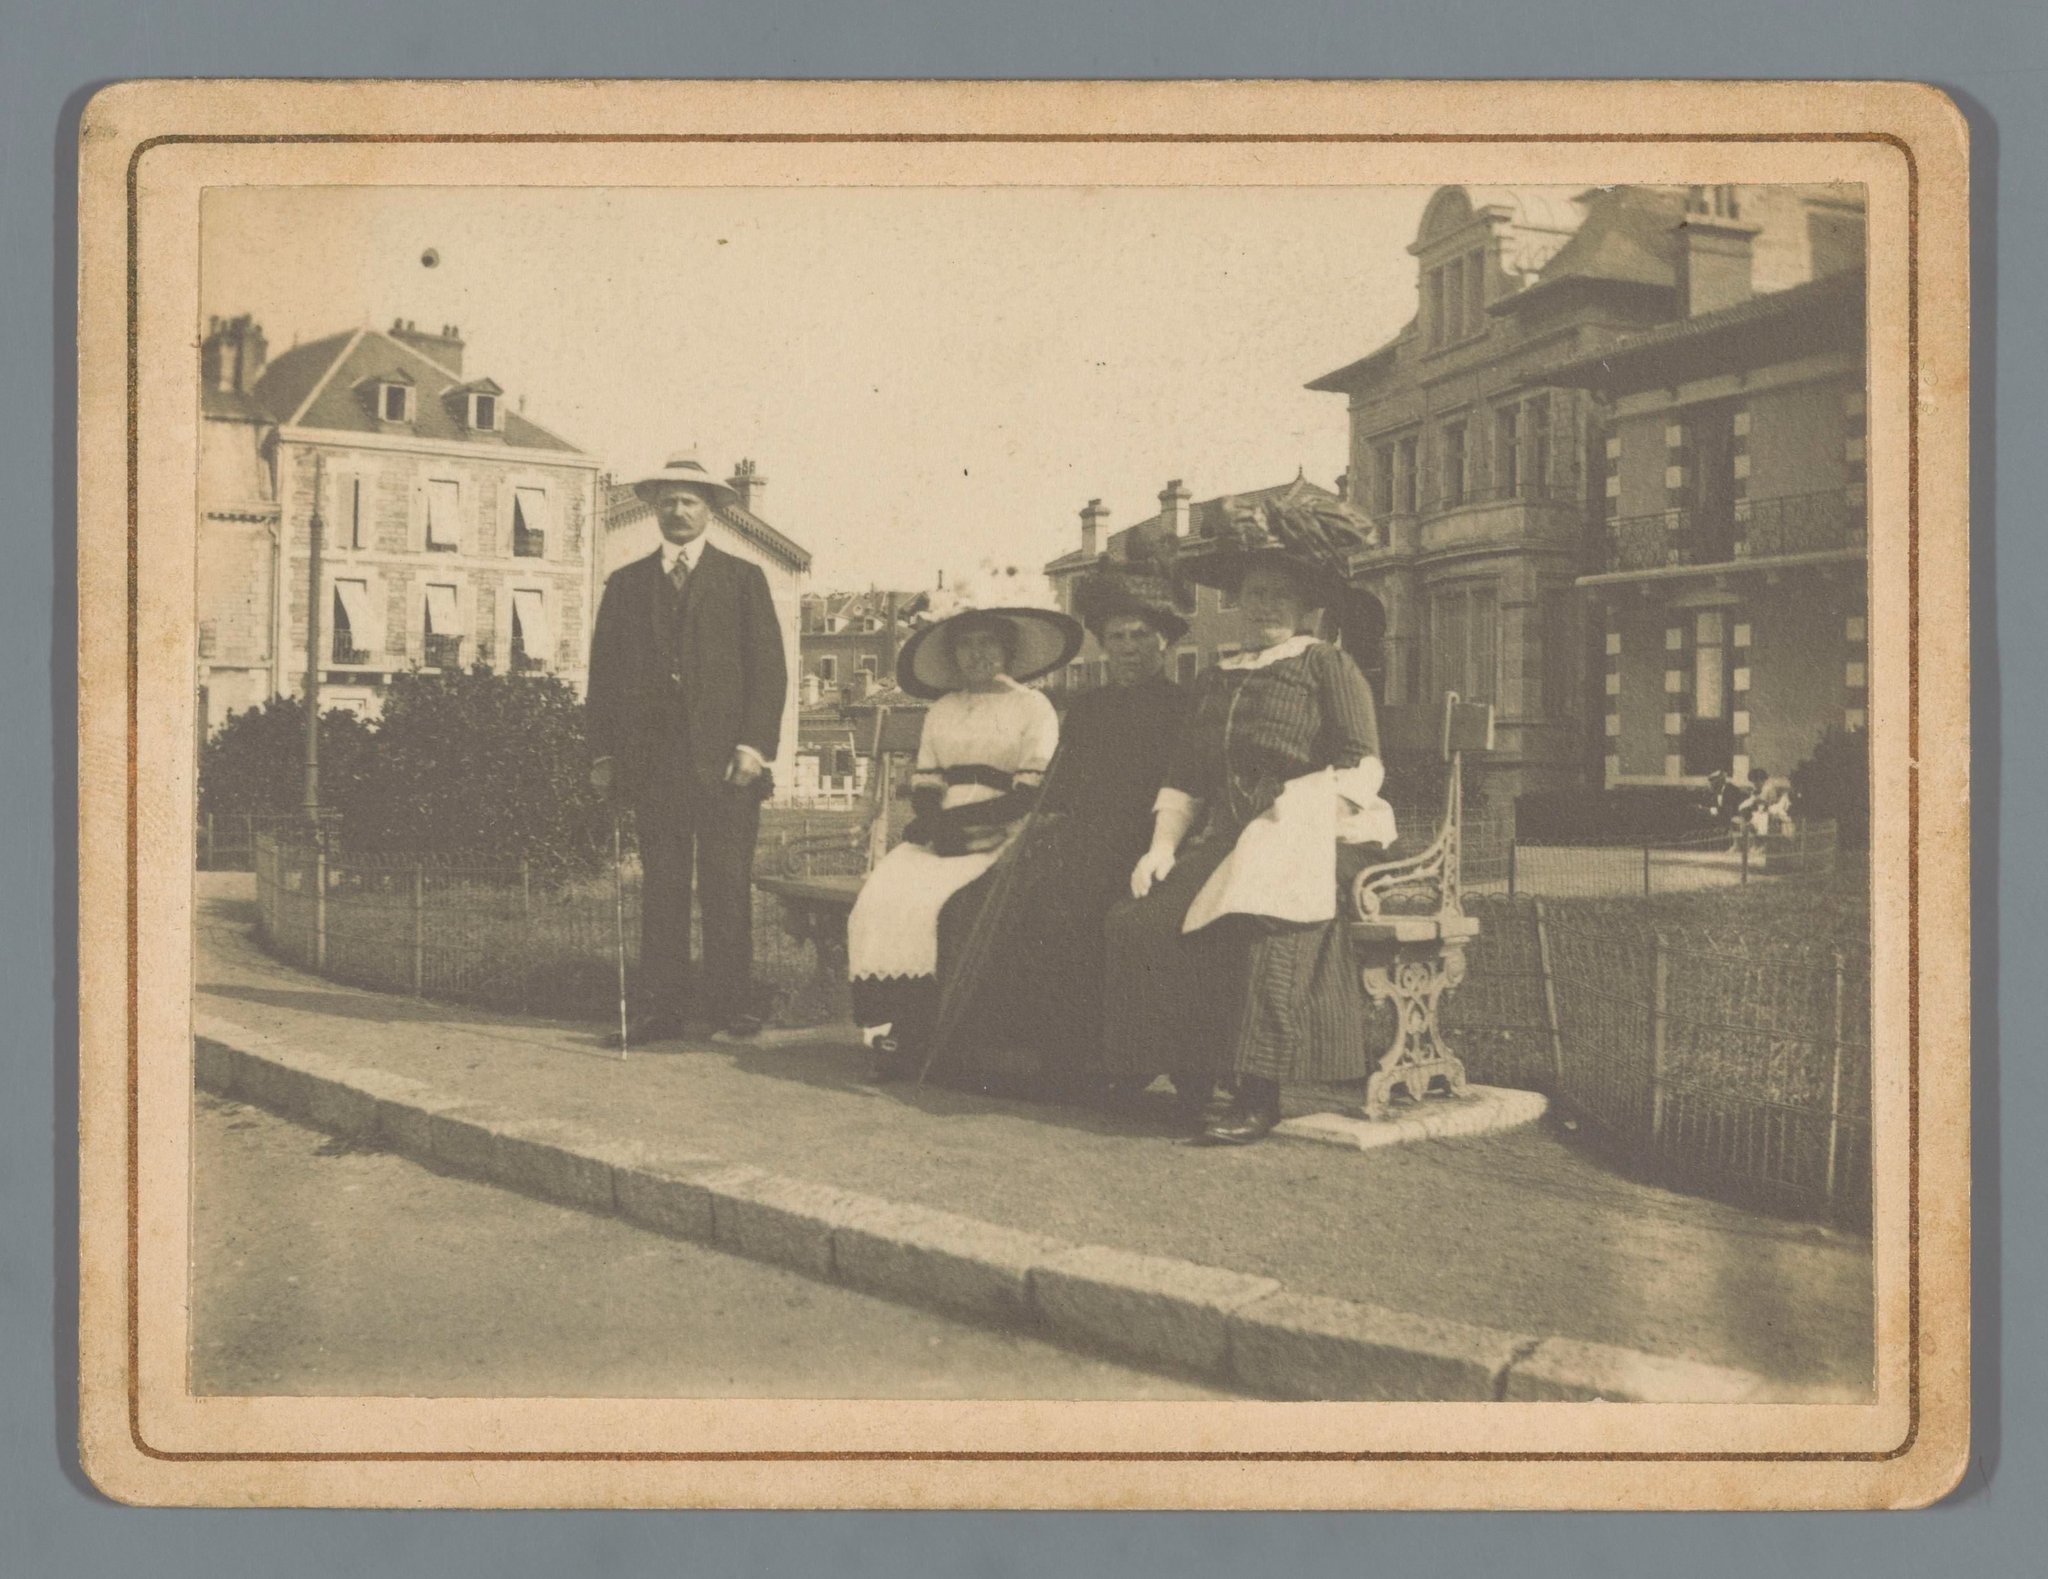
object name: photograph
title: Groepsportret van drie onbekende vrouwen op een bank en een staande man (vermoedelijk) te Biarritz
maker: Anonymous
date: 1912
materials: cardboard, photographic support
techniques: gelatin silver print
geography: biarritz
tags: street, anonymous historical persons portrayed in a group, in a group-portrait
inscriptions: inscription: ‘Souvenir de Biarritz Saint Loubes 20 septembre 1912’